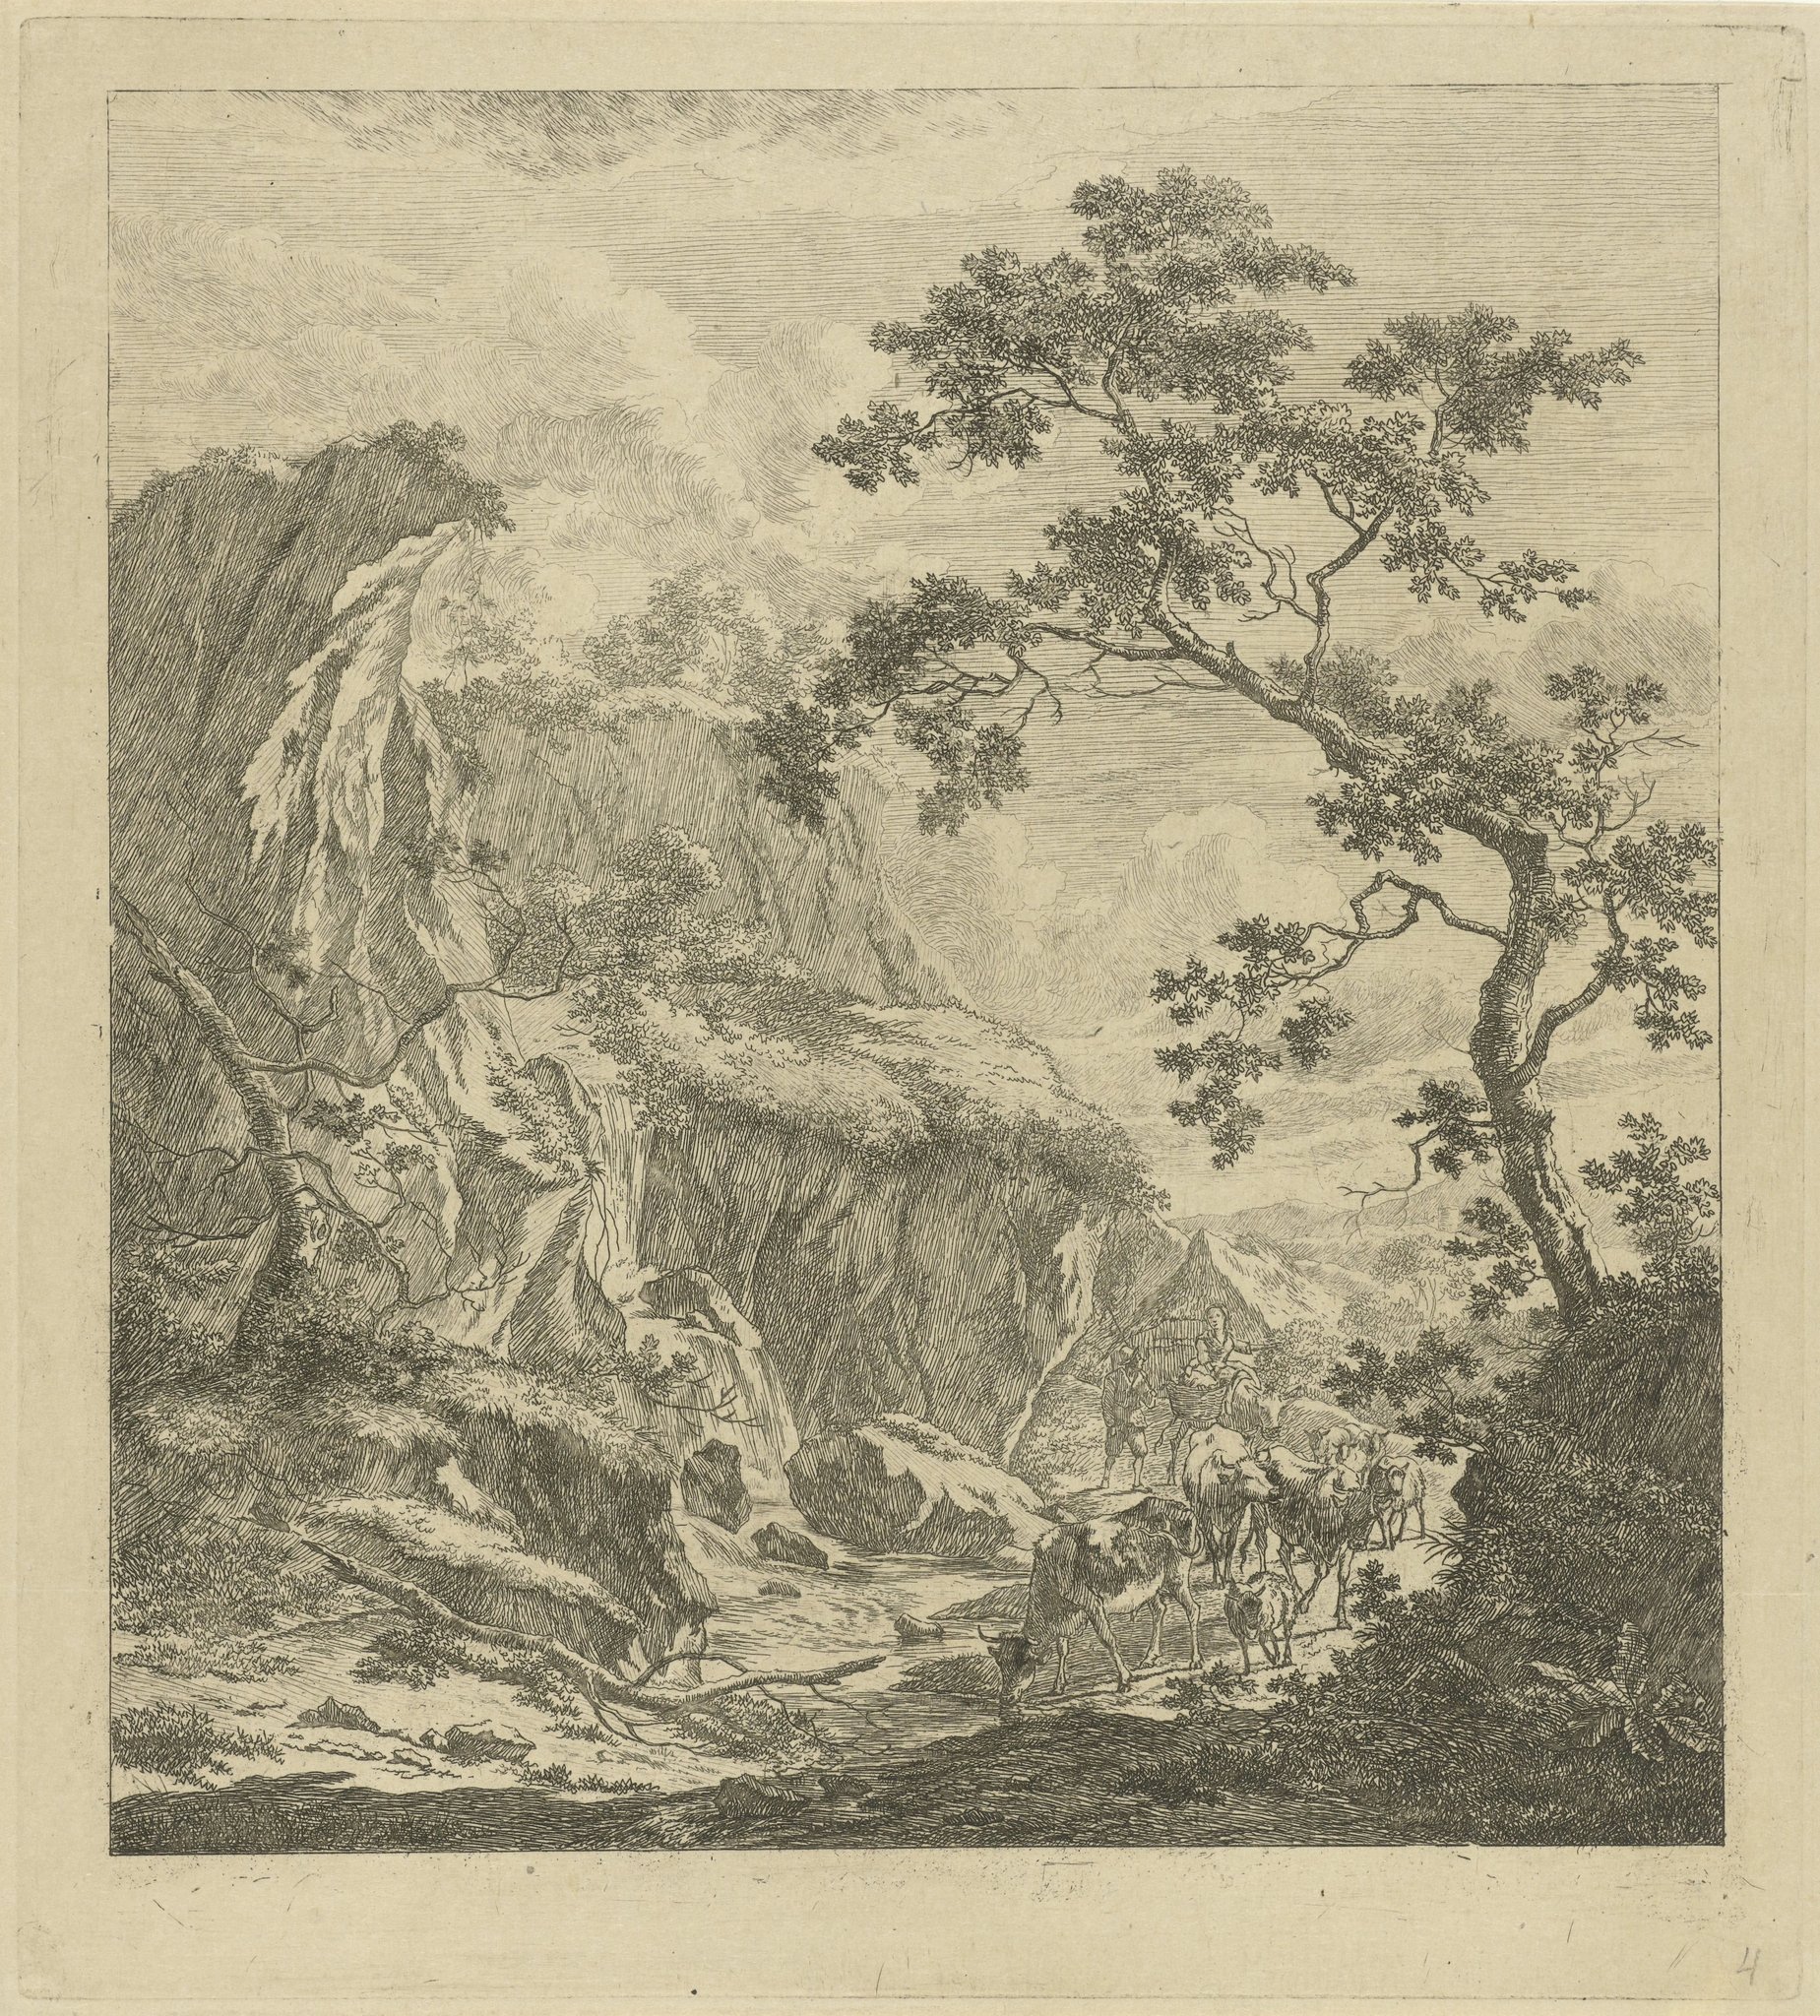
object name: print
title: Bergachtig landschap met vee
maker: johannes janson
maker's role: draughtsman, painter, print maker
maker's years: 1729-1784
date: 1761-1784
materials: paper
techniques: etching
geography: leiden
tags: ass, donkey, pastorals, arcadian scenes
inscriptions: collector's mark: Lugt 240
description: Landschap met bergpad waarop een herder en een herderin, rijdend op een ezel, met hun vee. Op de voorgrond drinkt een koe uit een beek.